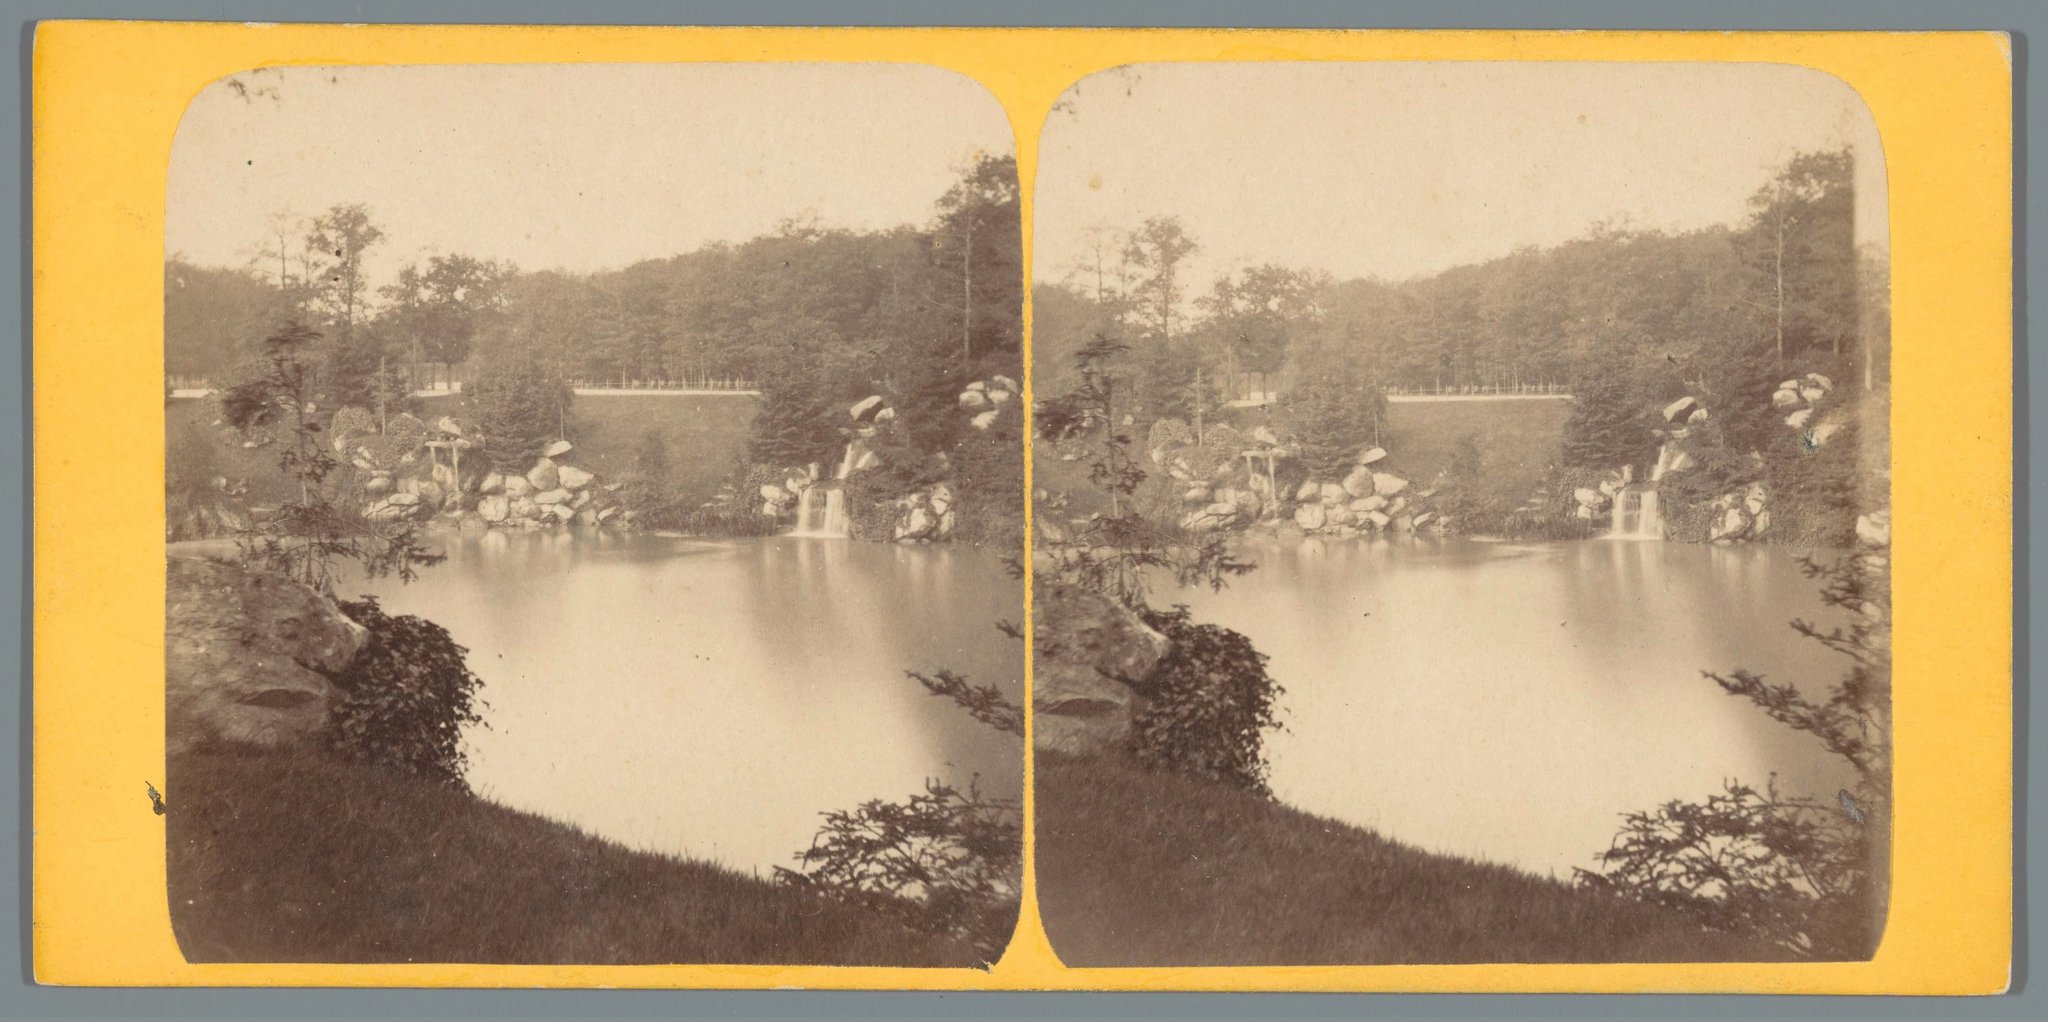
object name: stereograph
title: Gezicht op een meer en een waterval in het Bois de Boulogne in Parijs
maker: Anonymous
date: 1850-1880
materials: cardboard, photographic support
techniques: albumen print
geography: bois de boulogne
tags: lake, public gardens, park, garden cascade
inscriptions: inscription: ‘La riviere au Bois de Boulogne’, number: ‘47.’